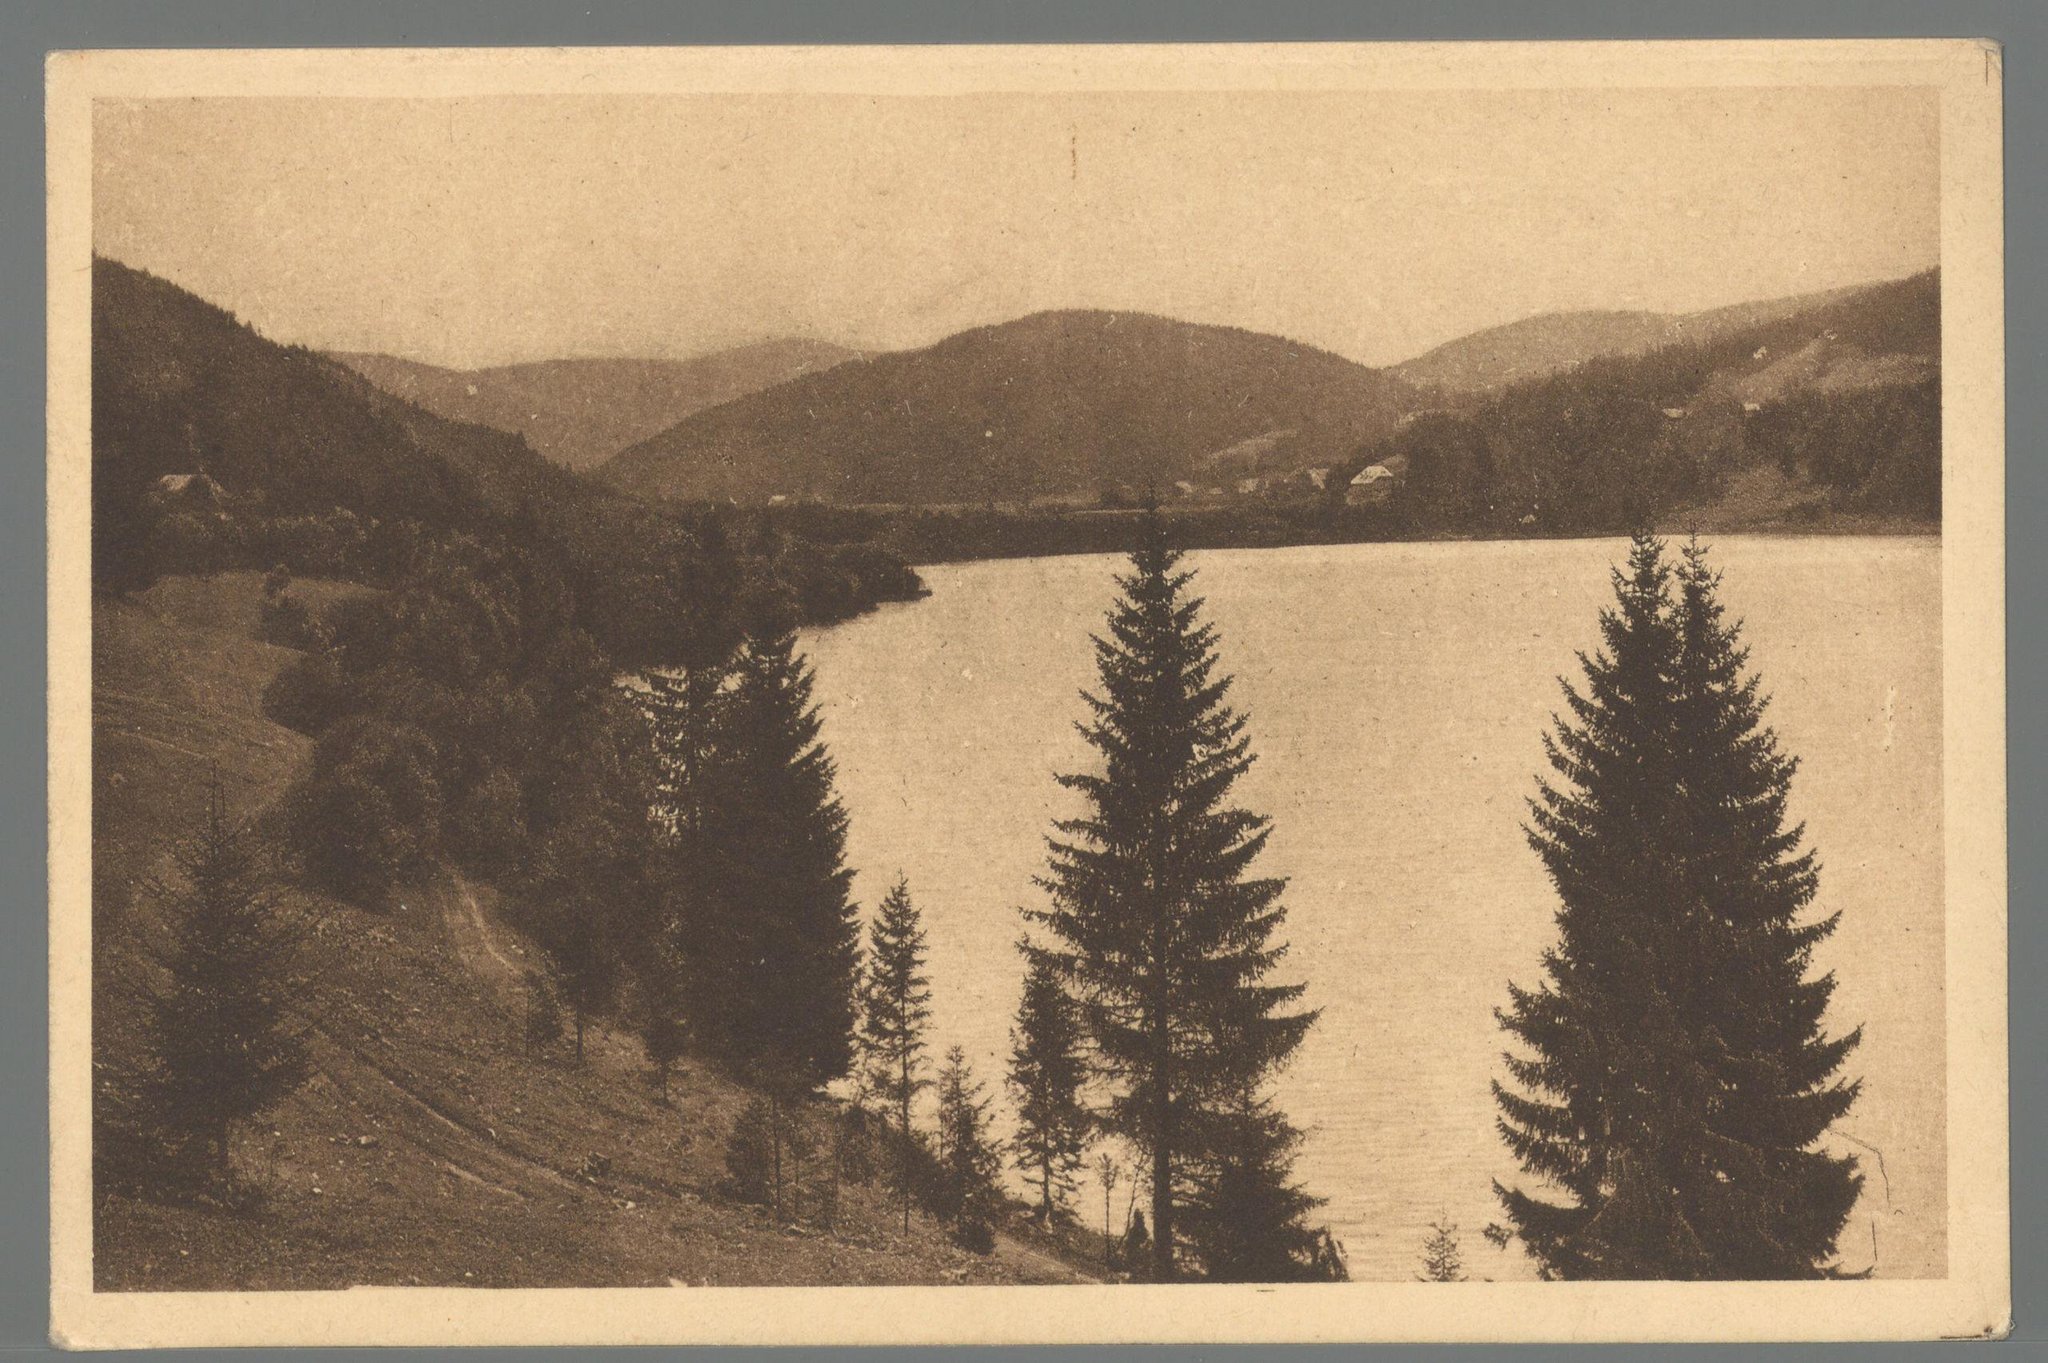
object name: photomechanical print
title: Titisee (Schwarzwald)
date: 1906-1930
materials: cardboard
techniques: photograph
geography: freiburg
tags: lake, forest, wood